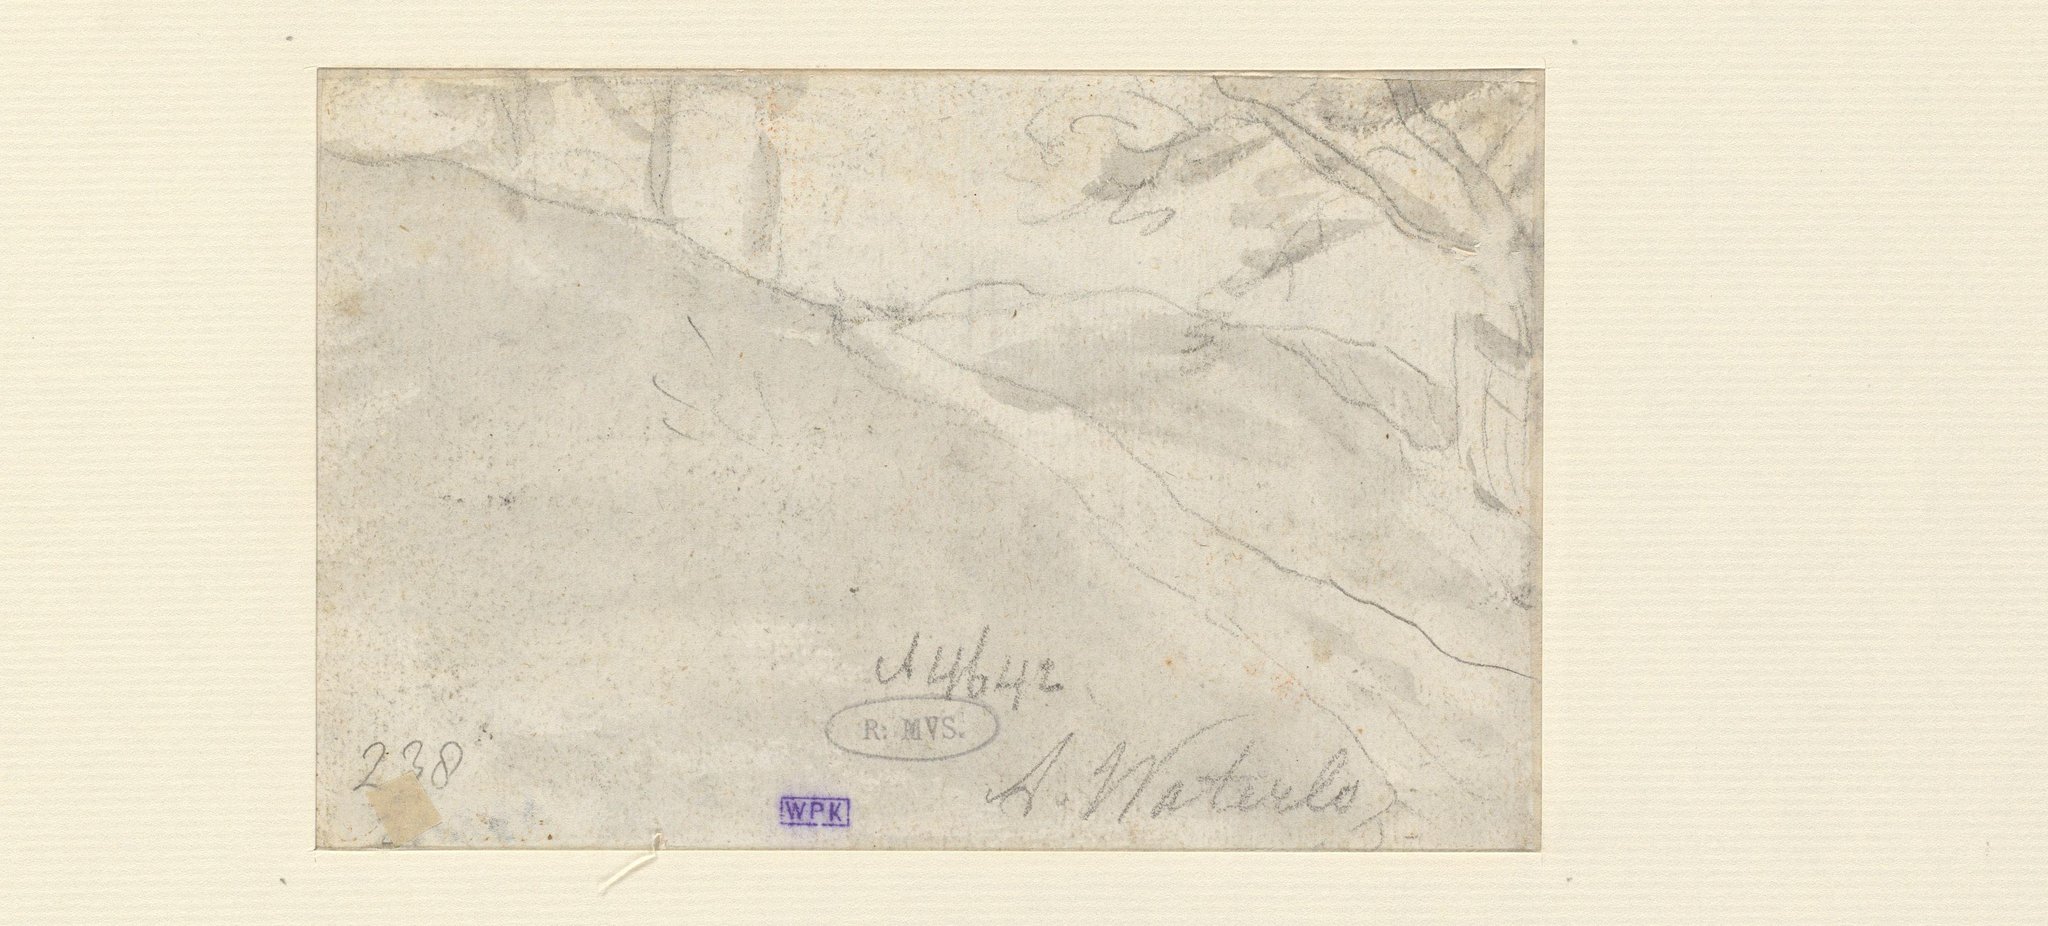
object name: drawing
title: Schets van een heuvelrug met bomen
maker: anthonie waterloo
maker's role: draughtsman, painter, print maker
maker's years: 1609-1690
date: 1619-1690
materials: chalk, paper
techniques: brush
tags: low hill country